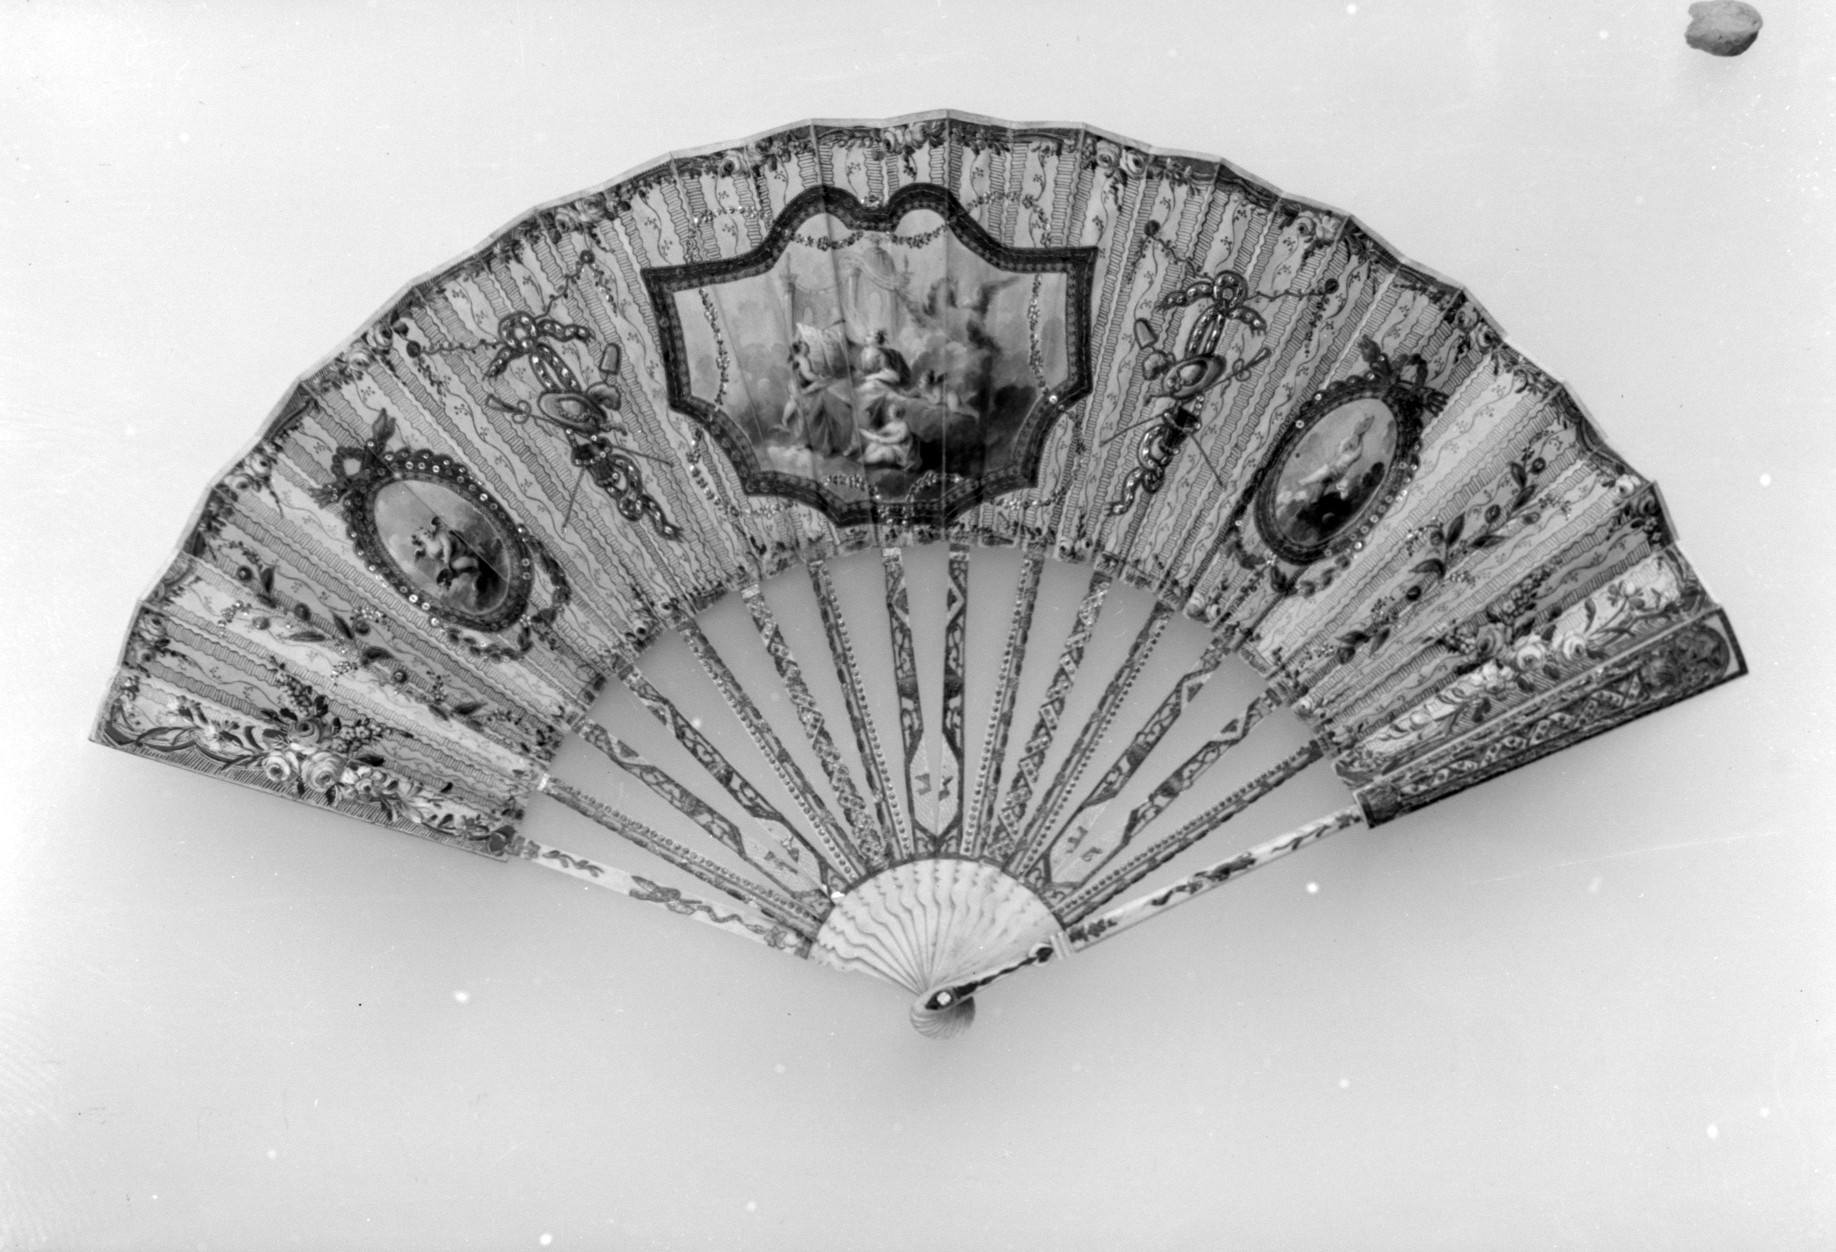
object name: fan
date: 1701-1800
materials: ivory, silk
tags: women